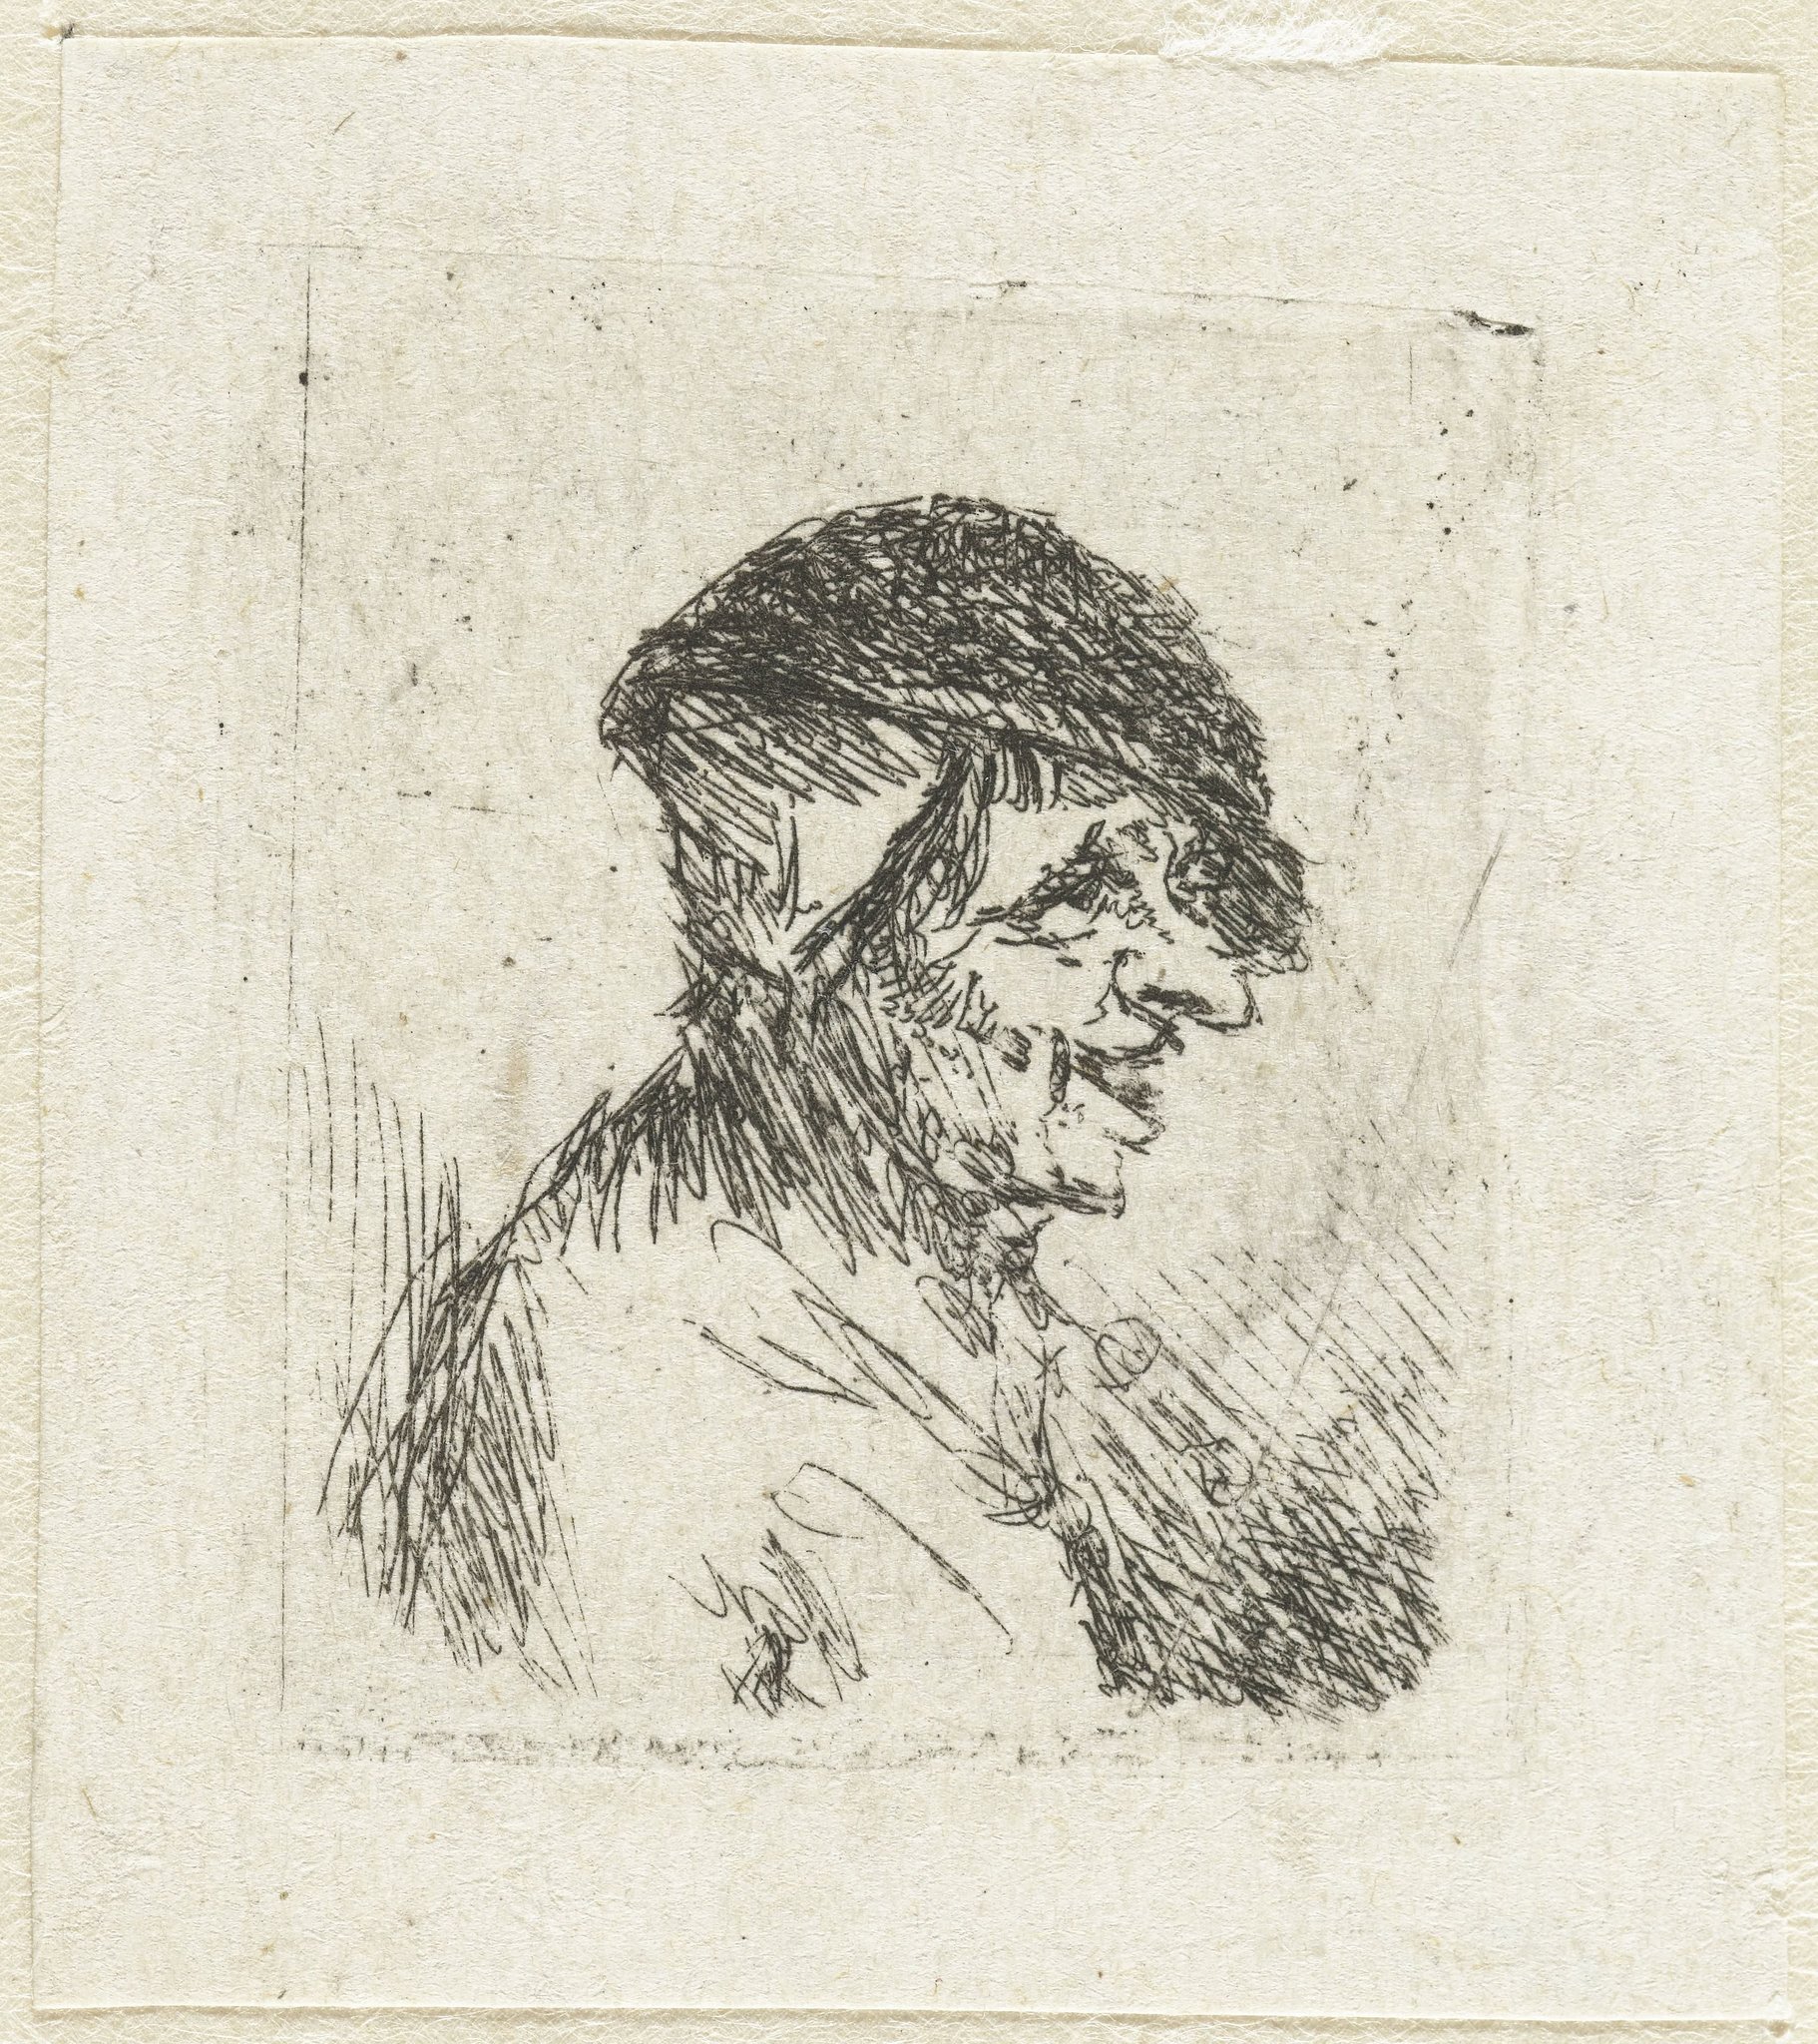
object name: print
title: Buste van een lachende boer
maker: adriaen van ostade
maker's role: draughtsman, painter, print maker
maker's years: 1610-1685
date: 1650-1652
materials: paper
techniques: etching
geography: haarlem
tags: laughing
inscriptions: collector's mark: Lugt 240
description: De buste van een lachende boer heeft een pendant met een vergelijkbare voorstelling van een lachende boerin. Zij is weergegeven vanuit een ander gezichtspunt zodat de koppen naar elkaar toe gewend zijn.